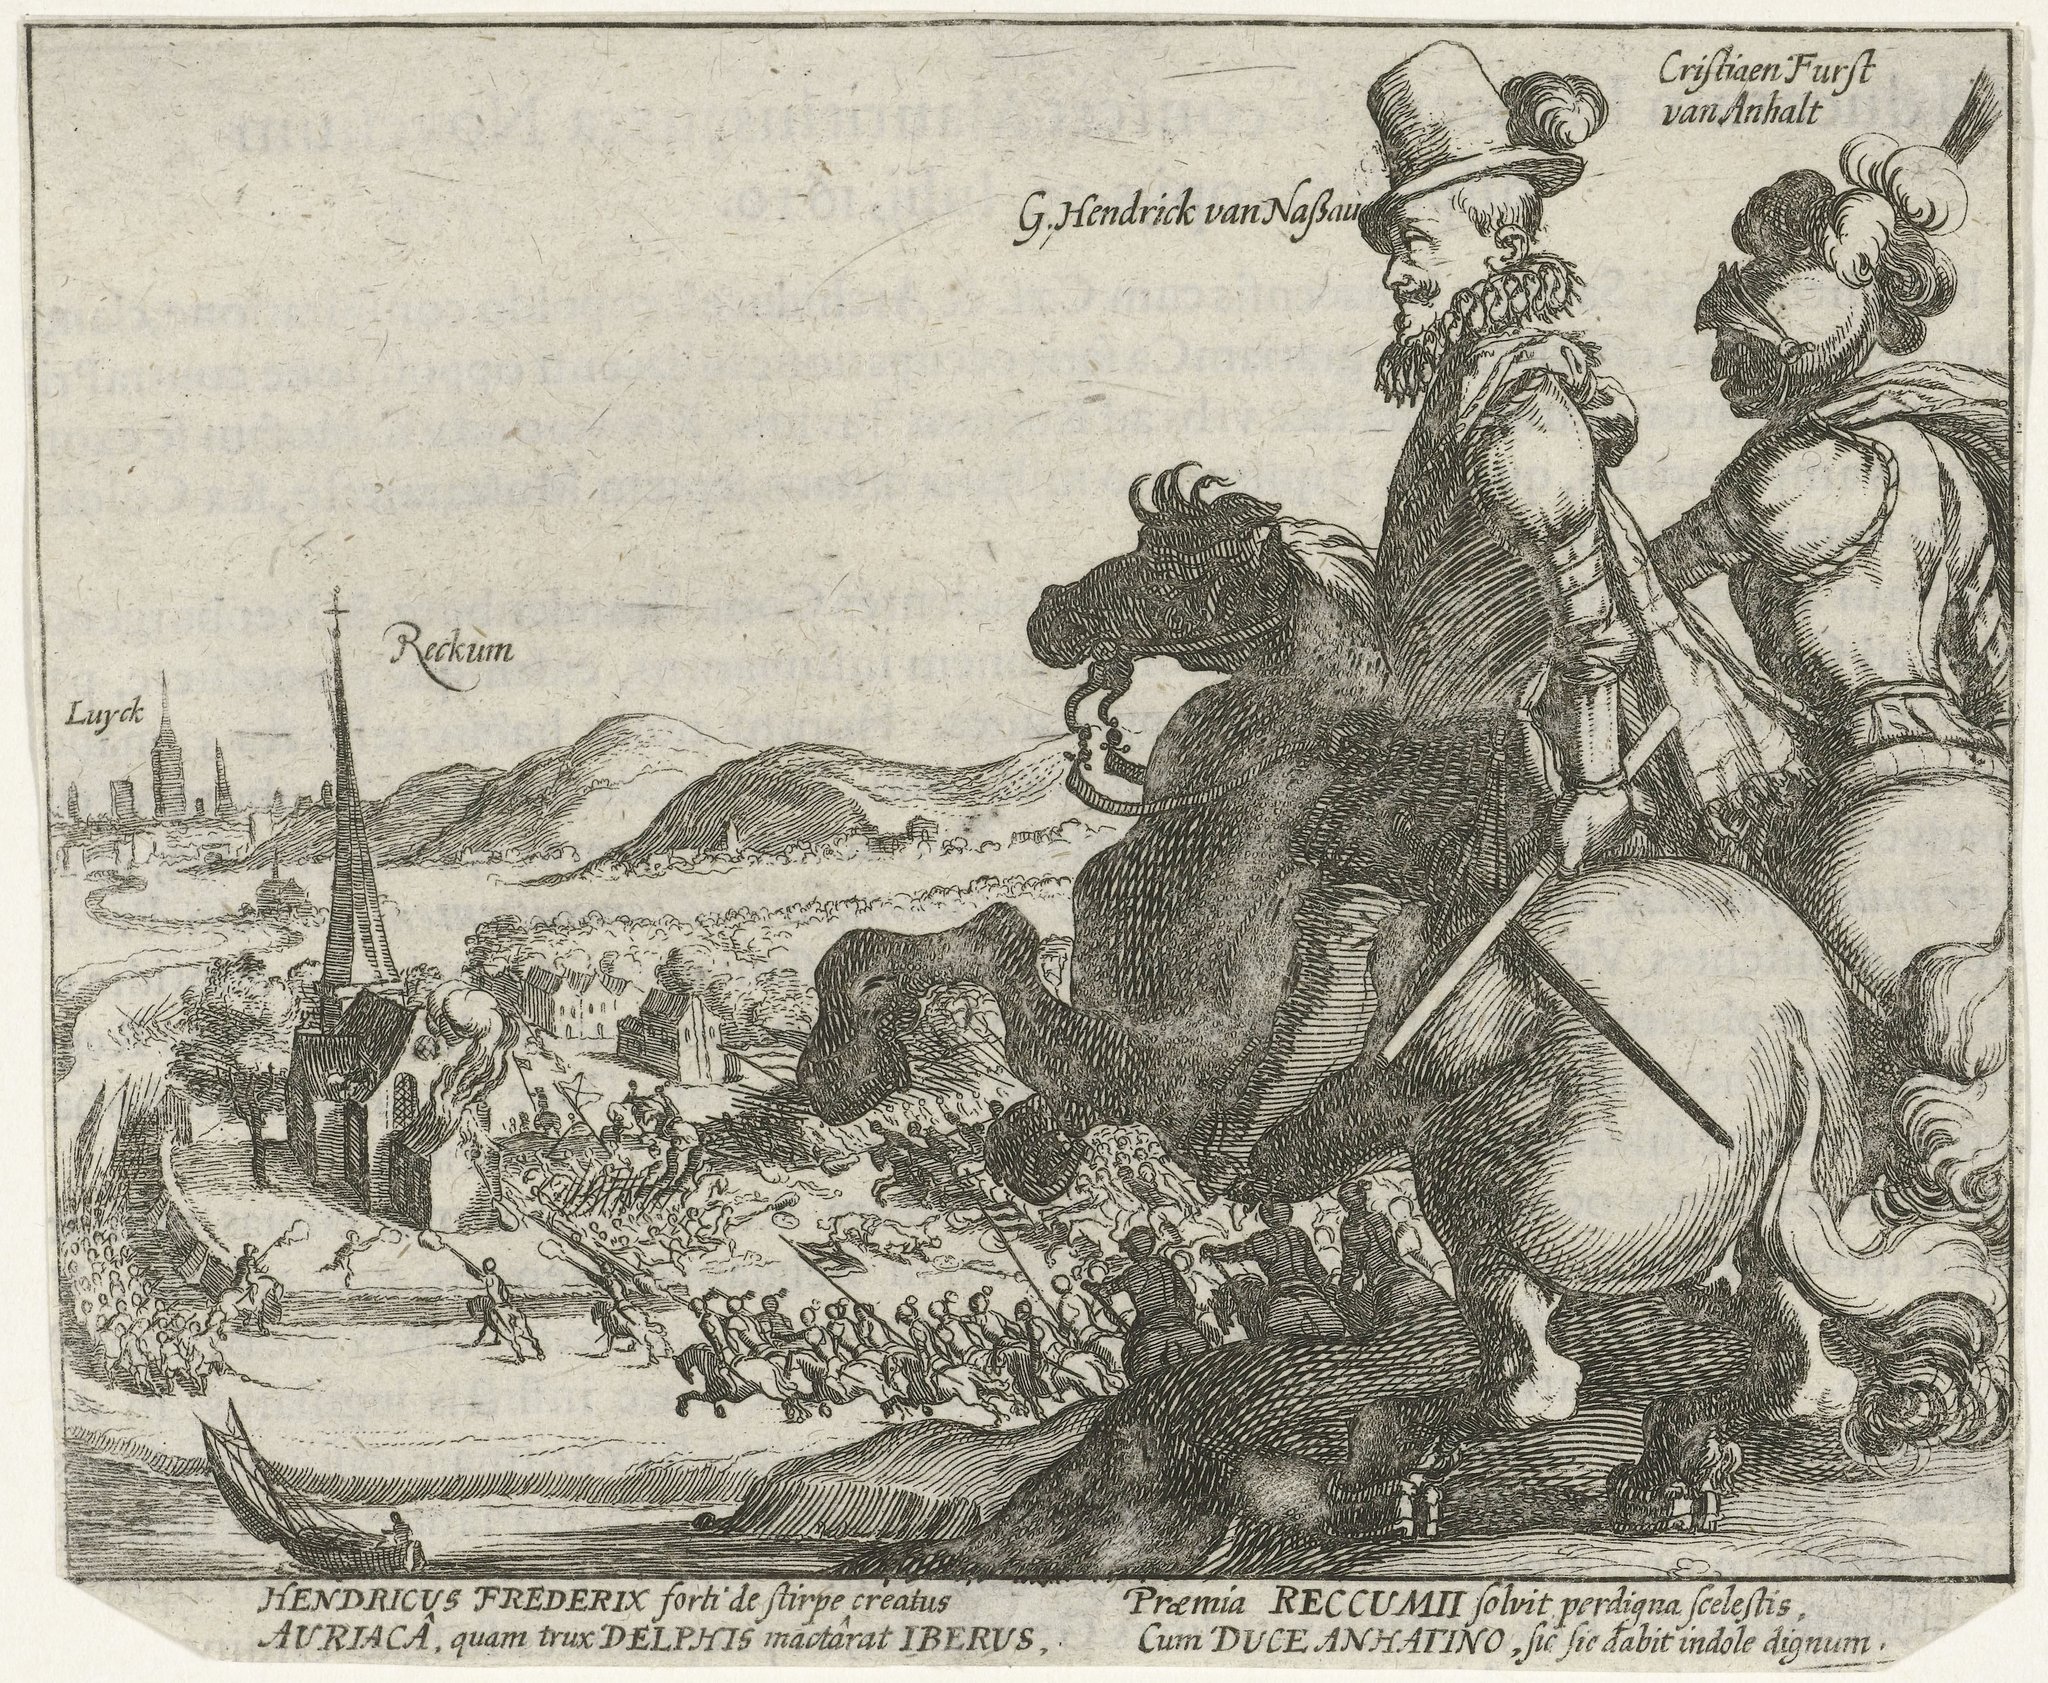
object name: history print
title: Frederik Hendrik en Christiaan van Anhalt verdrijven de Waalse troepen bij Rekem bij Maastricht, 1610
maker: simon frisius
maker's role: print maker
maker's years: 1570-1628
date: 1613-1615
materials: paper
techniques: etching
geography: northern netherlands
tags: frederick henry (prince of orange), raising the siege with outside assistance, relief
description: Frederik Hendrik en Christiaan van Anhalt verdrijven de Waalse troepen bij Rekem bij Maastricht, 1 mei 1610. De twee legeraanvoerders te paard op de voorgrond. Met onderschrift van 4 regels in het Latijn. Genummerd: 282 (afgesneden). Bedrukt op achterzijde met tekst in het Latijn.